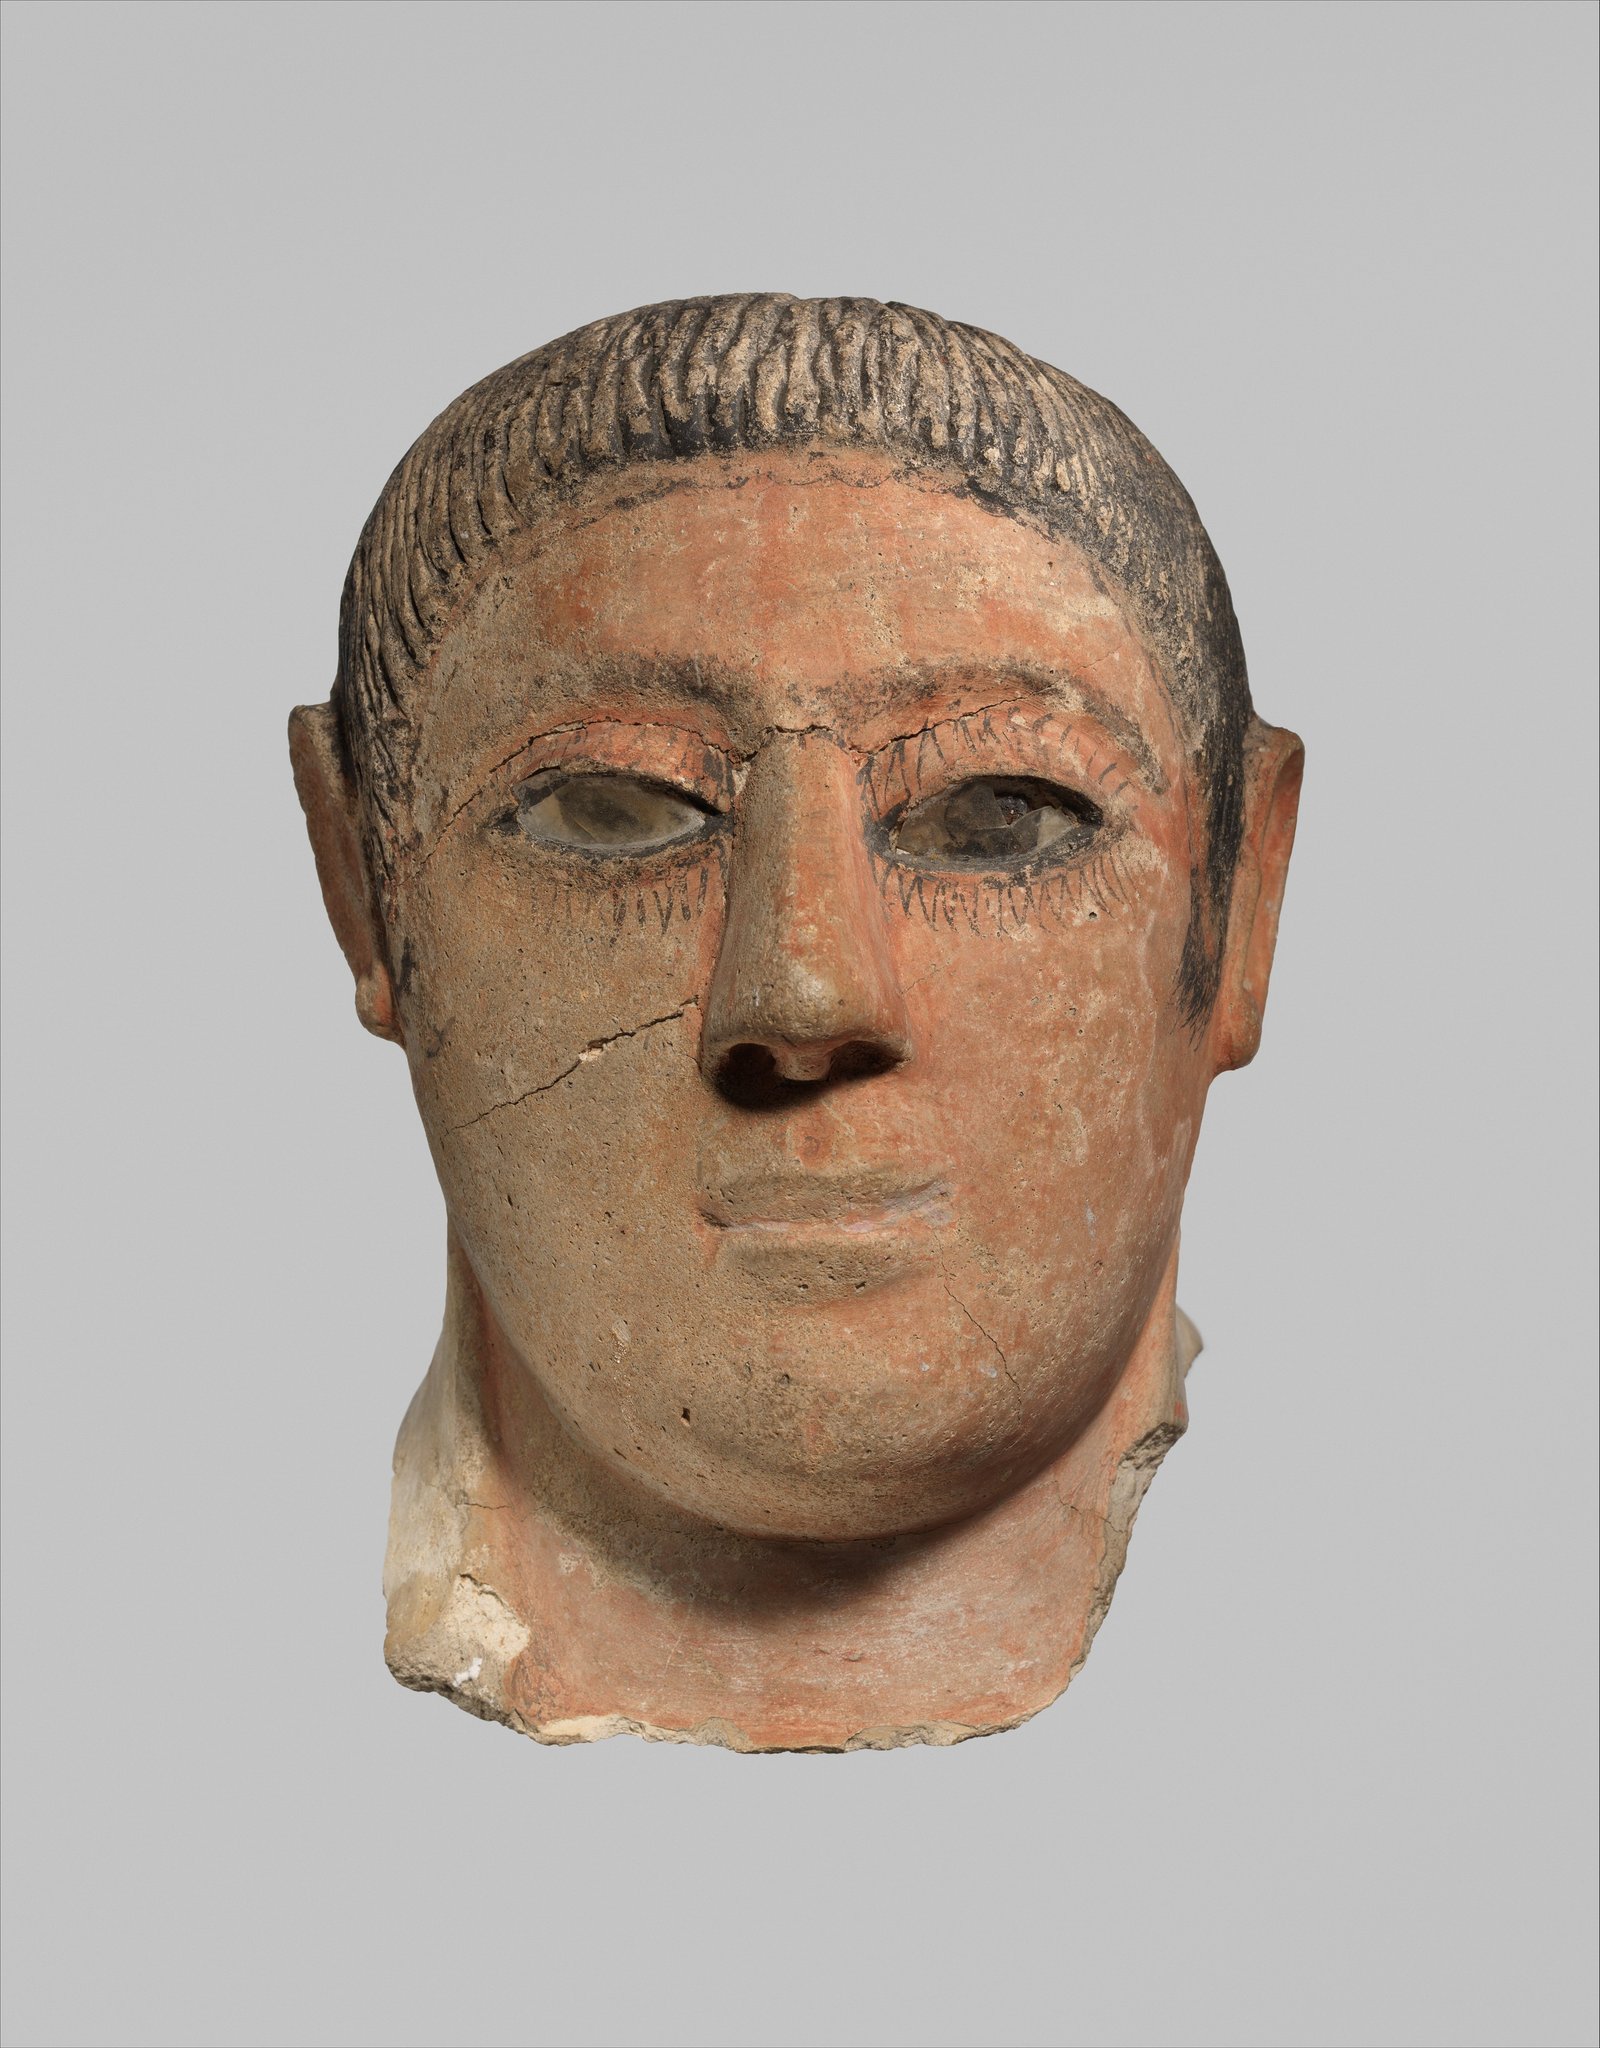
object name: mask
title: Funerary Mask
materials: paint, plaster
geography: egypt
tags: masks